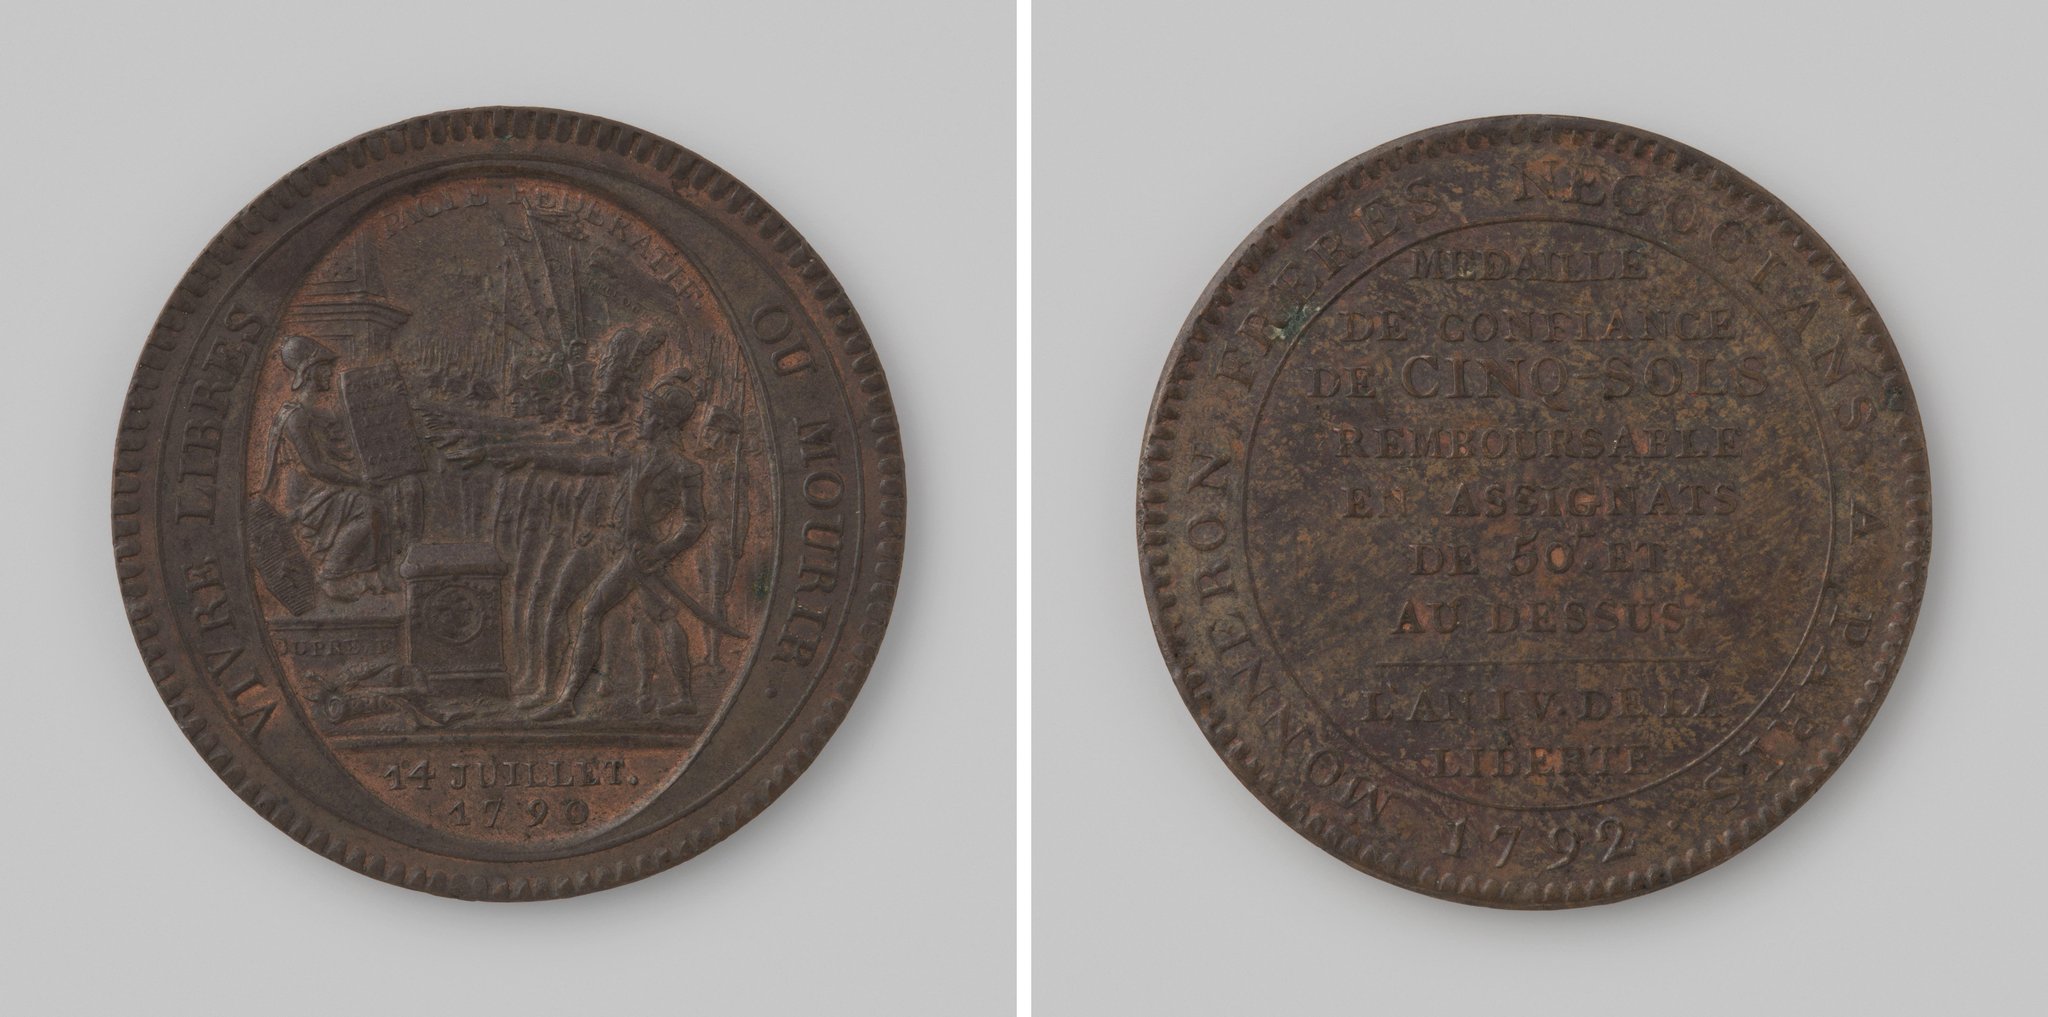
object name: coin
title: Frankrijk, particuliere 5 sols van de gebroeders Monneron,1792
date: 1792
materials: bronze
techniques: striking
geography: paris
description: Bronzen munt. Voorzijde: afbeelding van voor de vrijheid stijdende personen met een allegorische voorstelling. Keerzijde: vierregelig opschrift, waarin waarde-aanduiding. Daaronder jaartal in nieuwe telling: An 4. Jaartal onderaan. Randschrift.